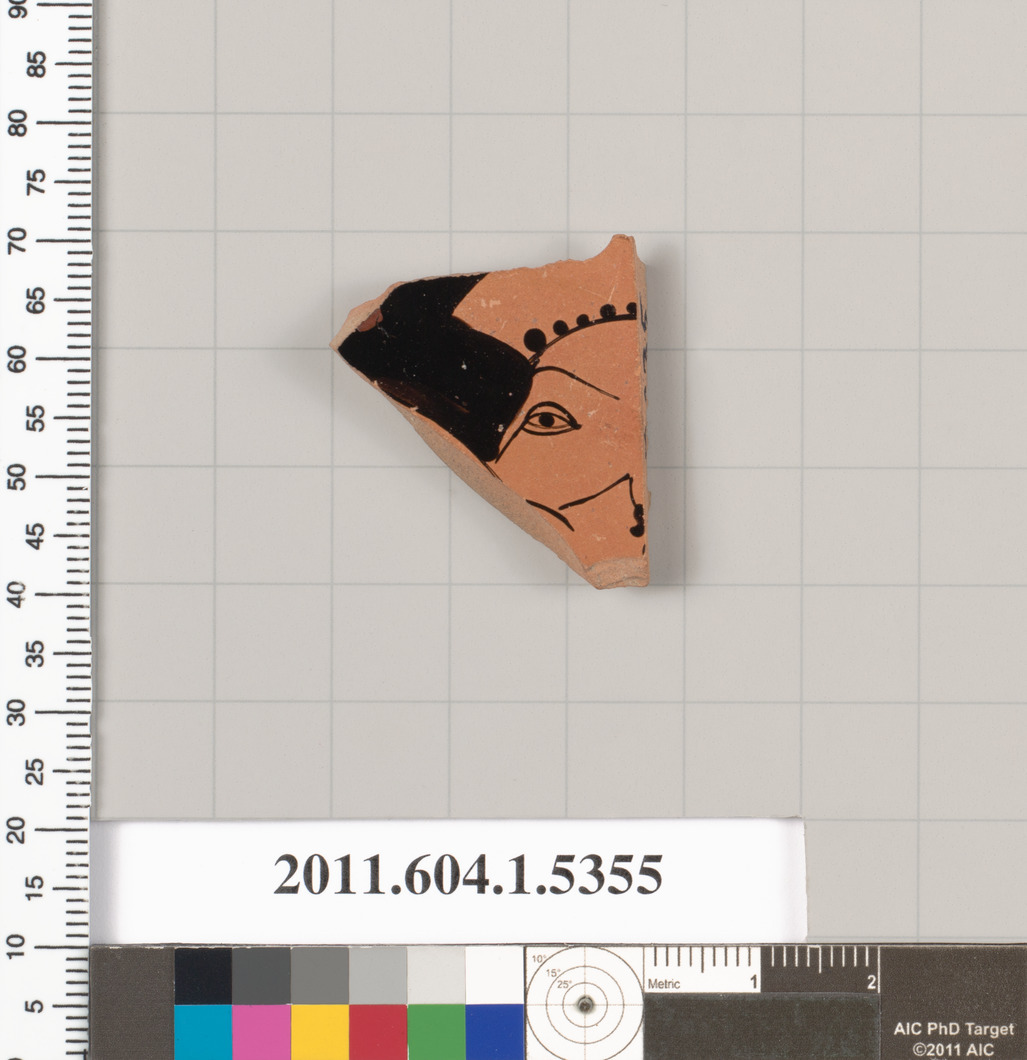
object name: kylix fragment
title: Terracotta fragment of a kylix (drinking cup)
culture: greek, attic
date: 520-510 BCE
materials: terracotta